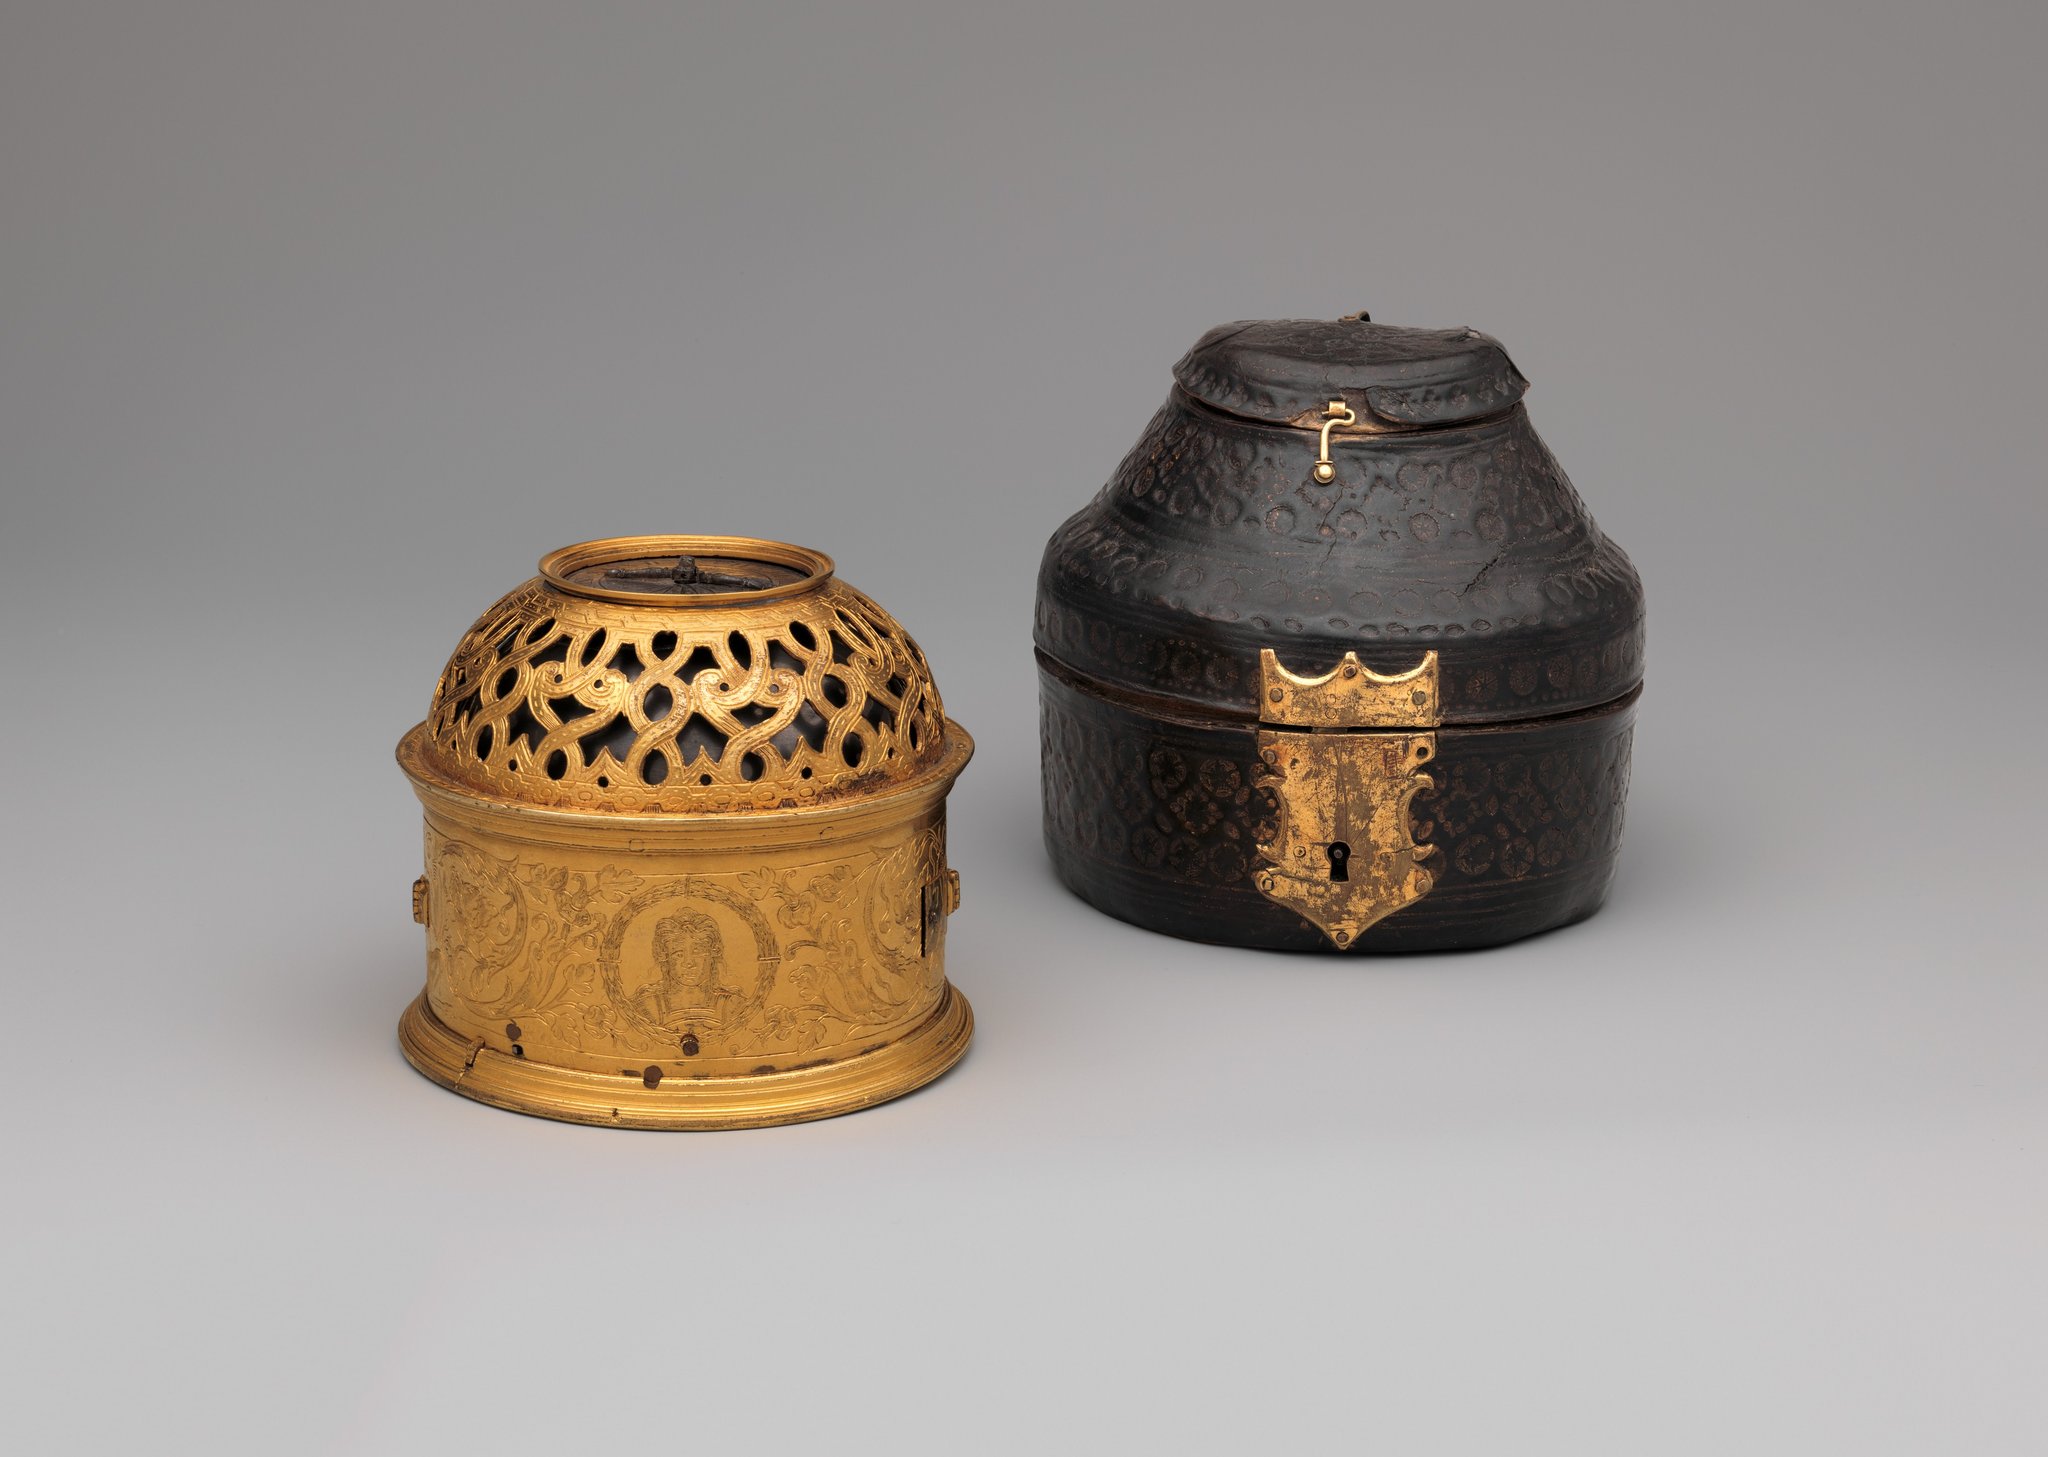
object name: traveling case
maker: bartholomew newsam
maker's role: maker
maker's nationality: british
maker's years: 1487-1587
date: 1580-1585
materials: brass, leather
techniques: gilding